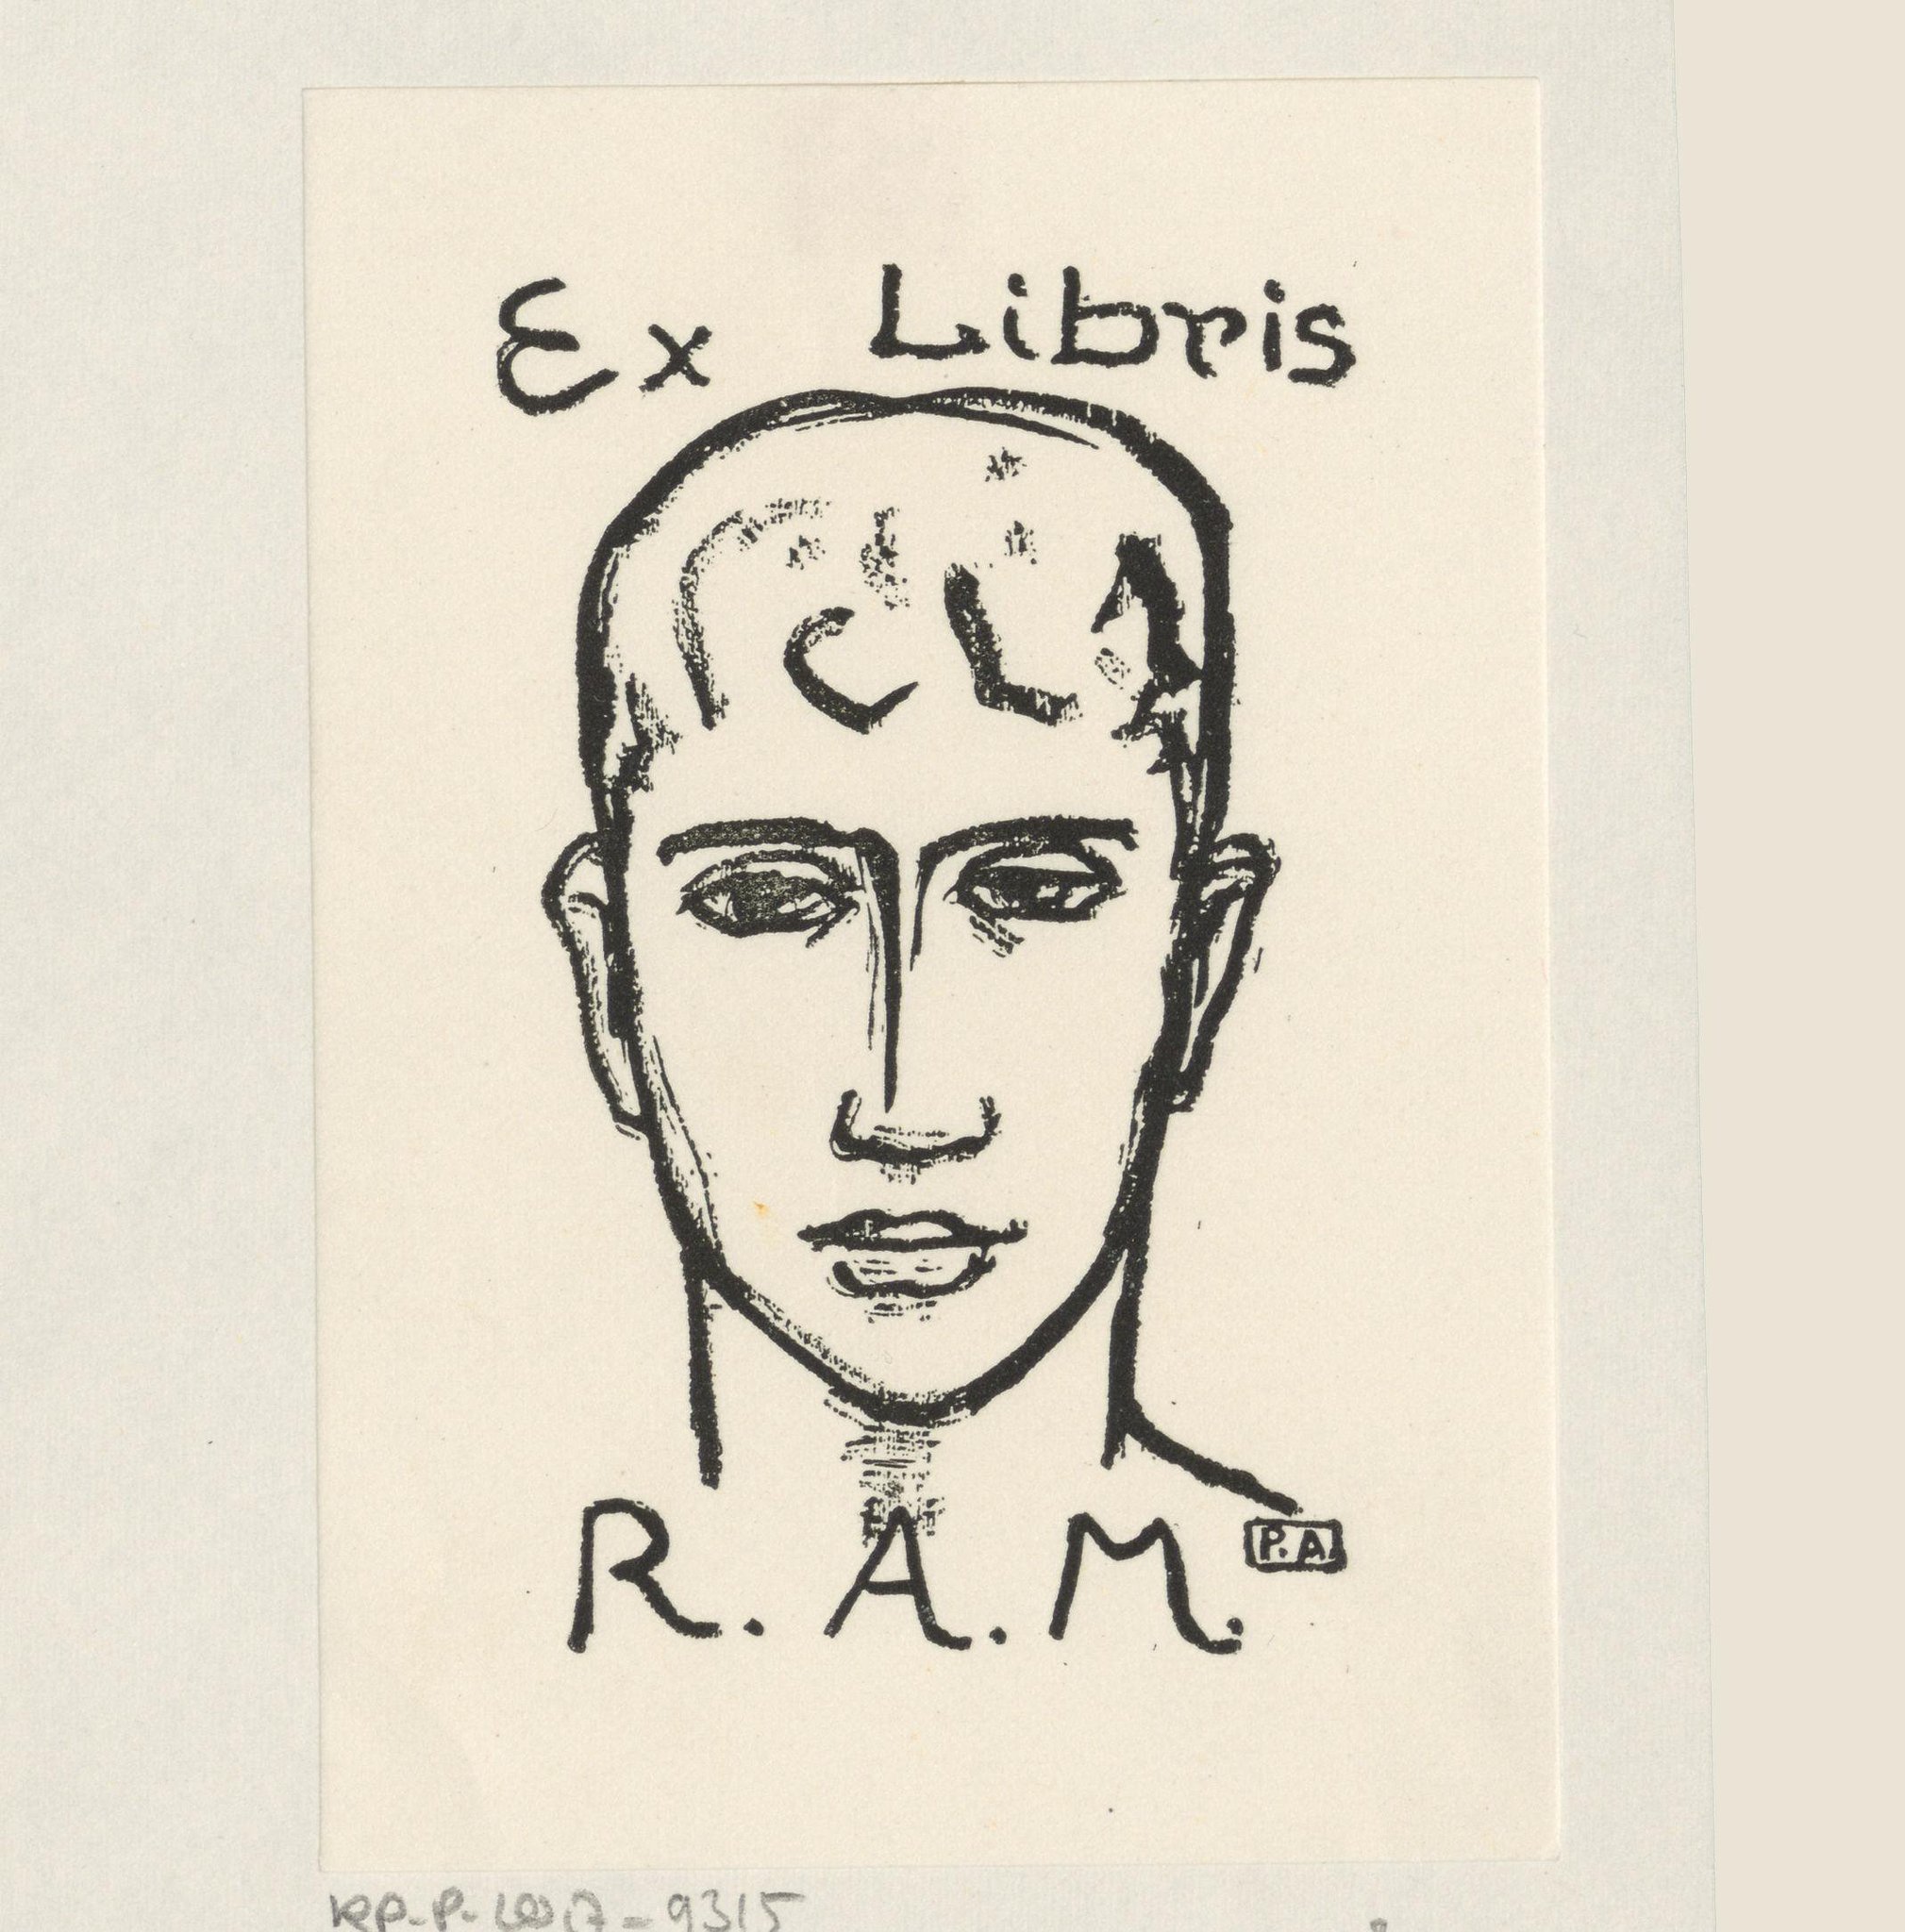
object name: bookplate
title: Ex libris van R.A.M.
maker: Anonymous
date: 1900-1999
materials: paper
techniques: lithograph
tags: head (human)